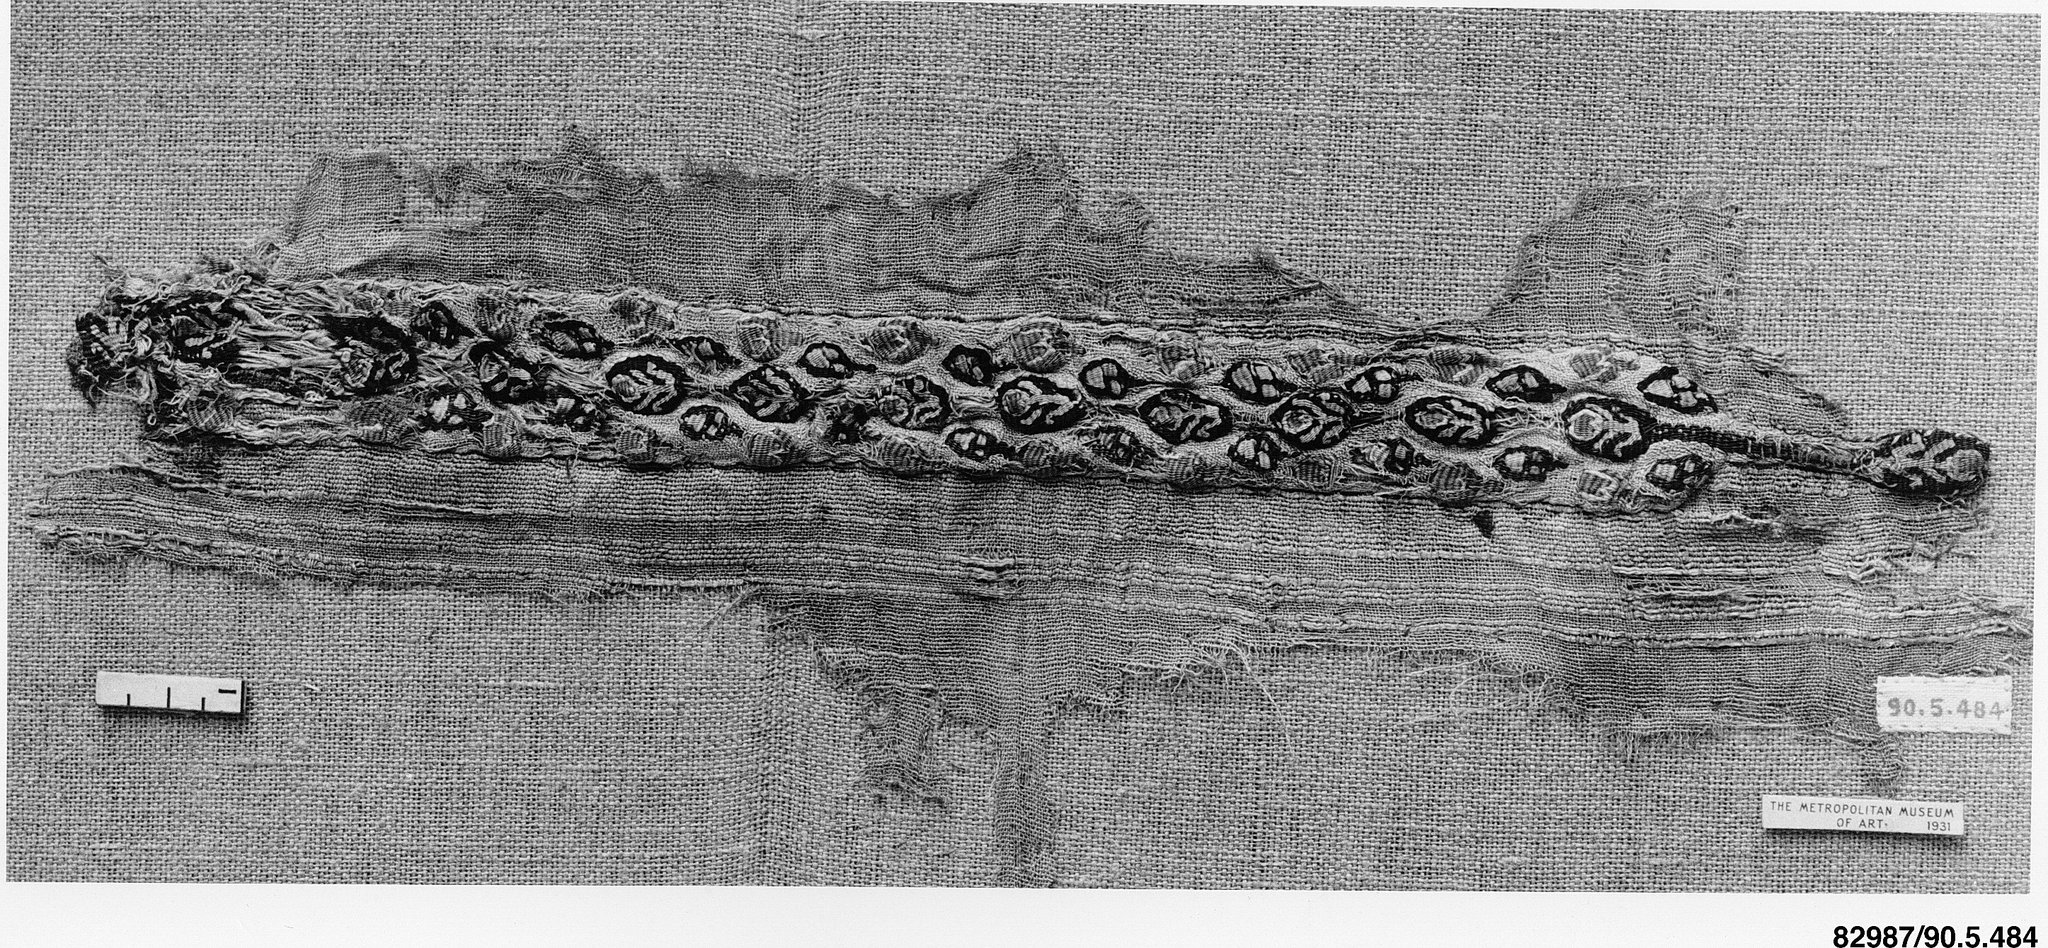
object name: textile fragment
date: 401-500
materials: linen, wool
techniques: weave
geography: egypt